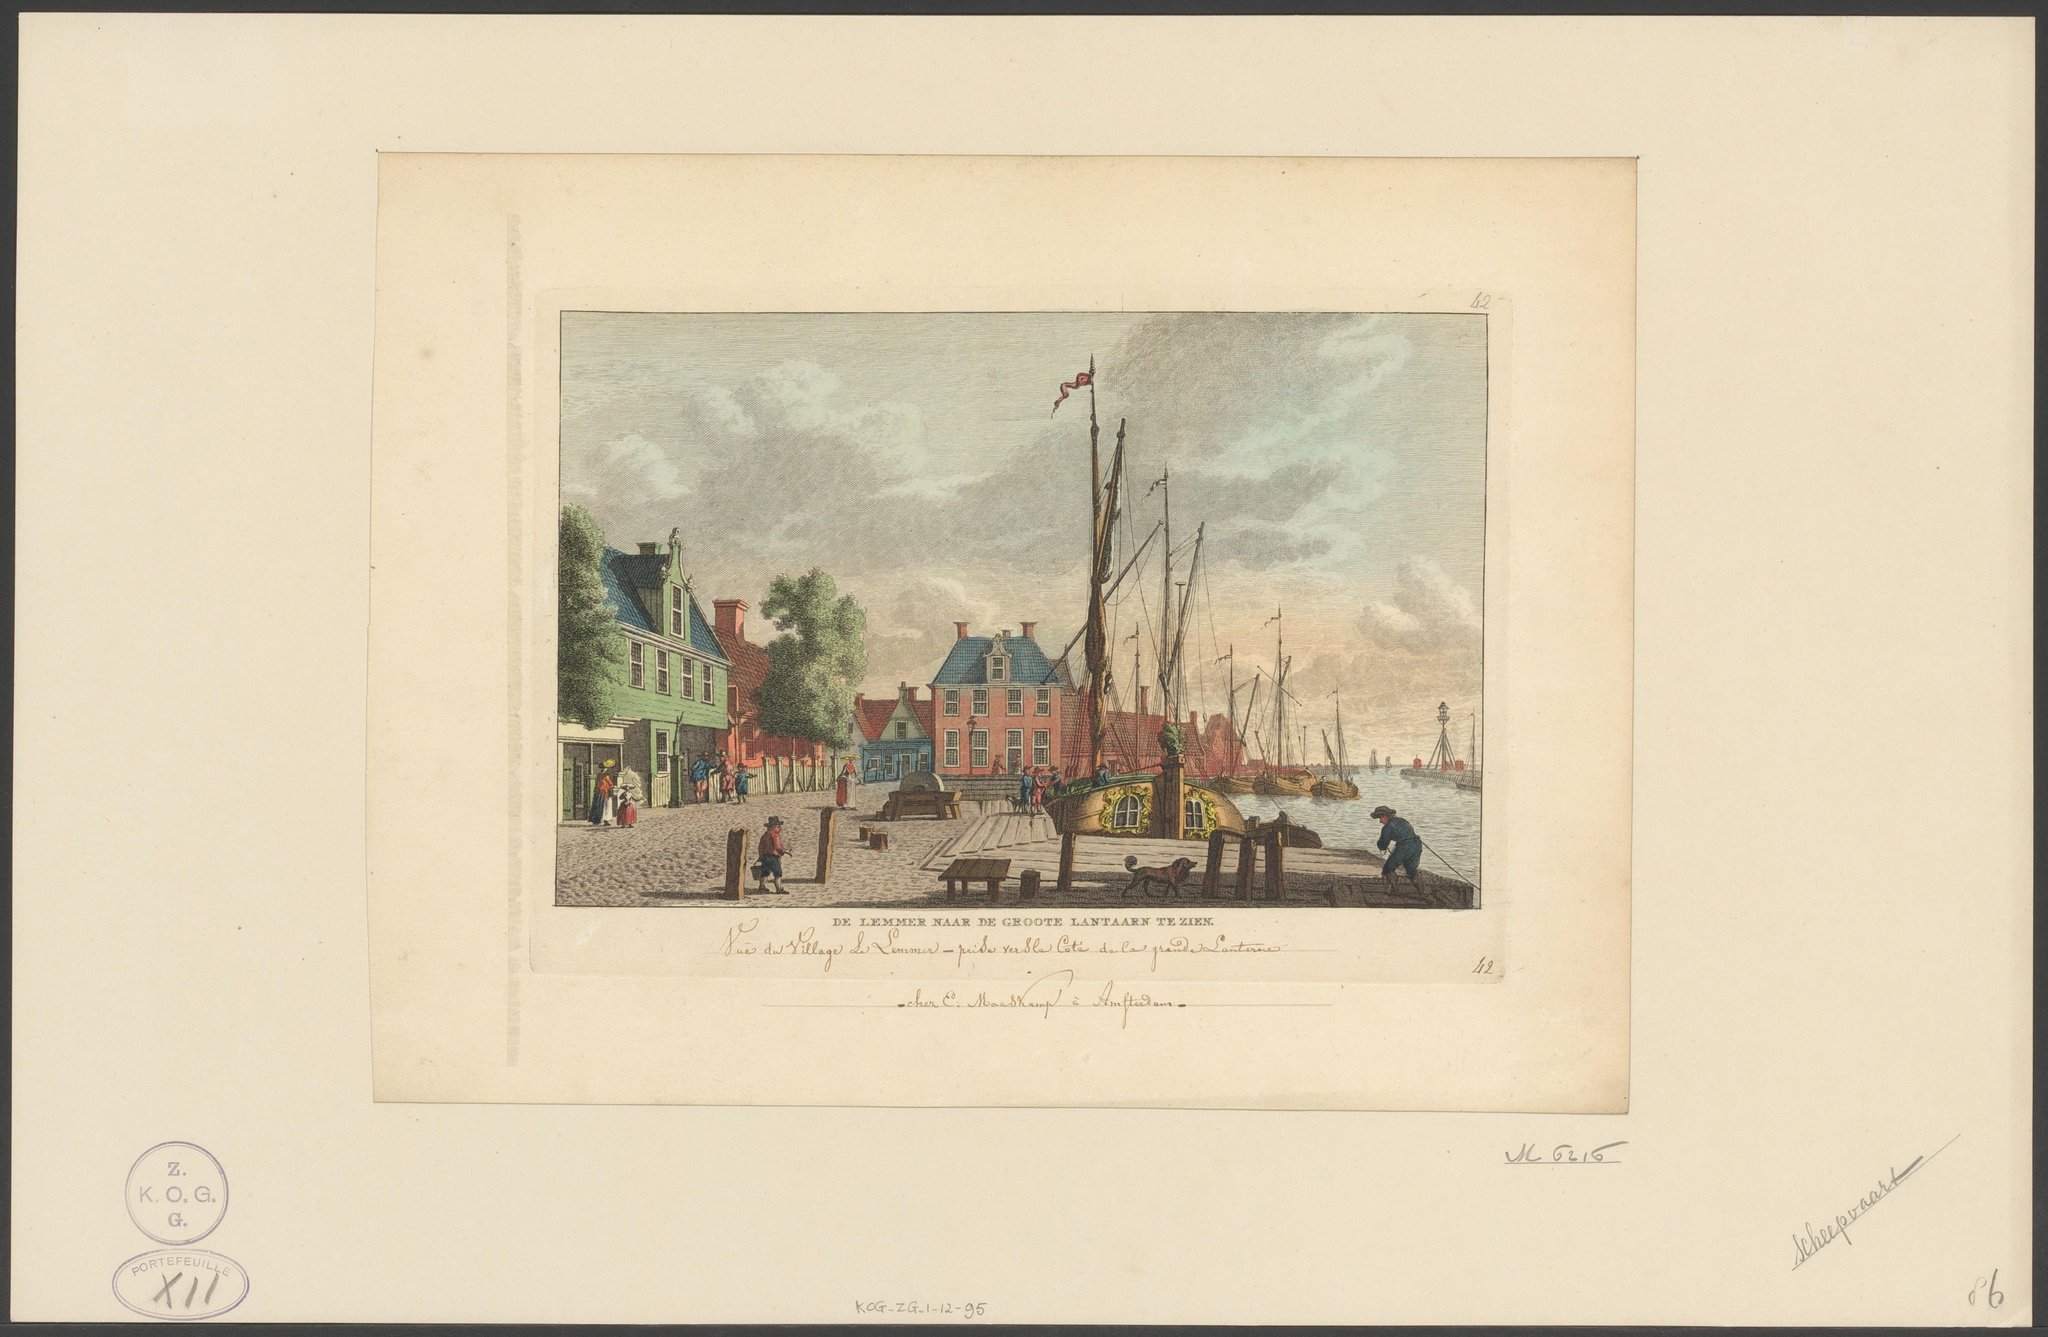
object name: print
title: De Lemmer naar de Groote Lantaarn te zien / Vue du Lemmer prisse vers le Coté del grande lanterne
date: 1824-1825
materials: paper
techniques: engraving, etching, hand coloring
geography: amsterdam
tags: harbour, beacon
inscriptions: stamp, collector's mark: Lugt 1641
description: Huidige staat van prent uitgegeven als onderdeel van een plaatwerk uit ca. 1824-1825 met 74 (ongenummerde) platen van de belangrijkste topografische gezichten en verschillende zeden en gewoonten in het Verenigd Koninkrijk der Nederlanden, getiteld 'Tableau des principales vues des palais et édifices : représentations et des coutumes et usages, dans les provinces septentrionales du Royaume des Pays-Bas'. Eerdere staat gebruikt in: Vaderlandsche gezichten, of afbeeldingen van den tegenwoordigen staat der Vereenigde Nederlanden (…). Amsterdam: Hendrik Gartman, Willem Vermandel en Jan Willem Smit, 1786-1792. Uitgegeven in afleveringen met ieder een eigen bifolium en inhoudsopgave. Alle prenten in deze publicatie zijn gegraveerd door Carel Frederik Bendorp (I) en, in de meeste gevallen, gebaseerd op tekeningen van Jan Bulthuis.